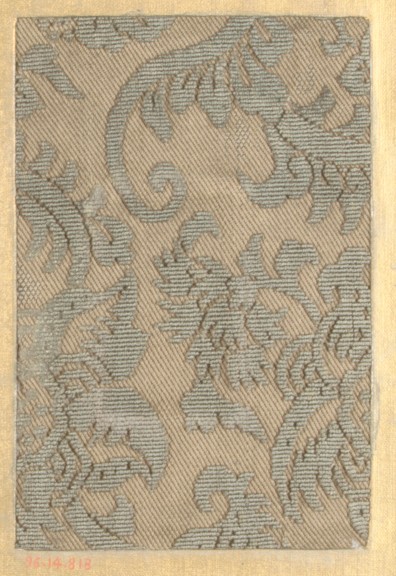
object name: piece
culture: japanese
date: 1701-1900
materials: silk